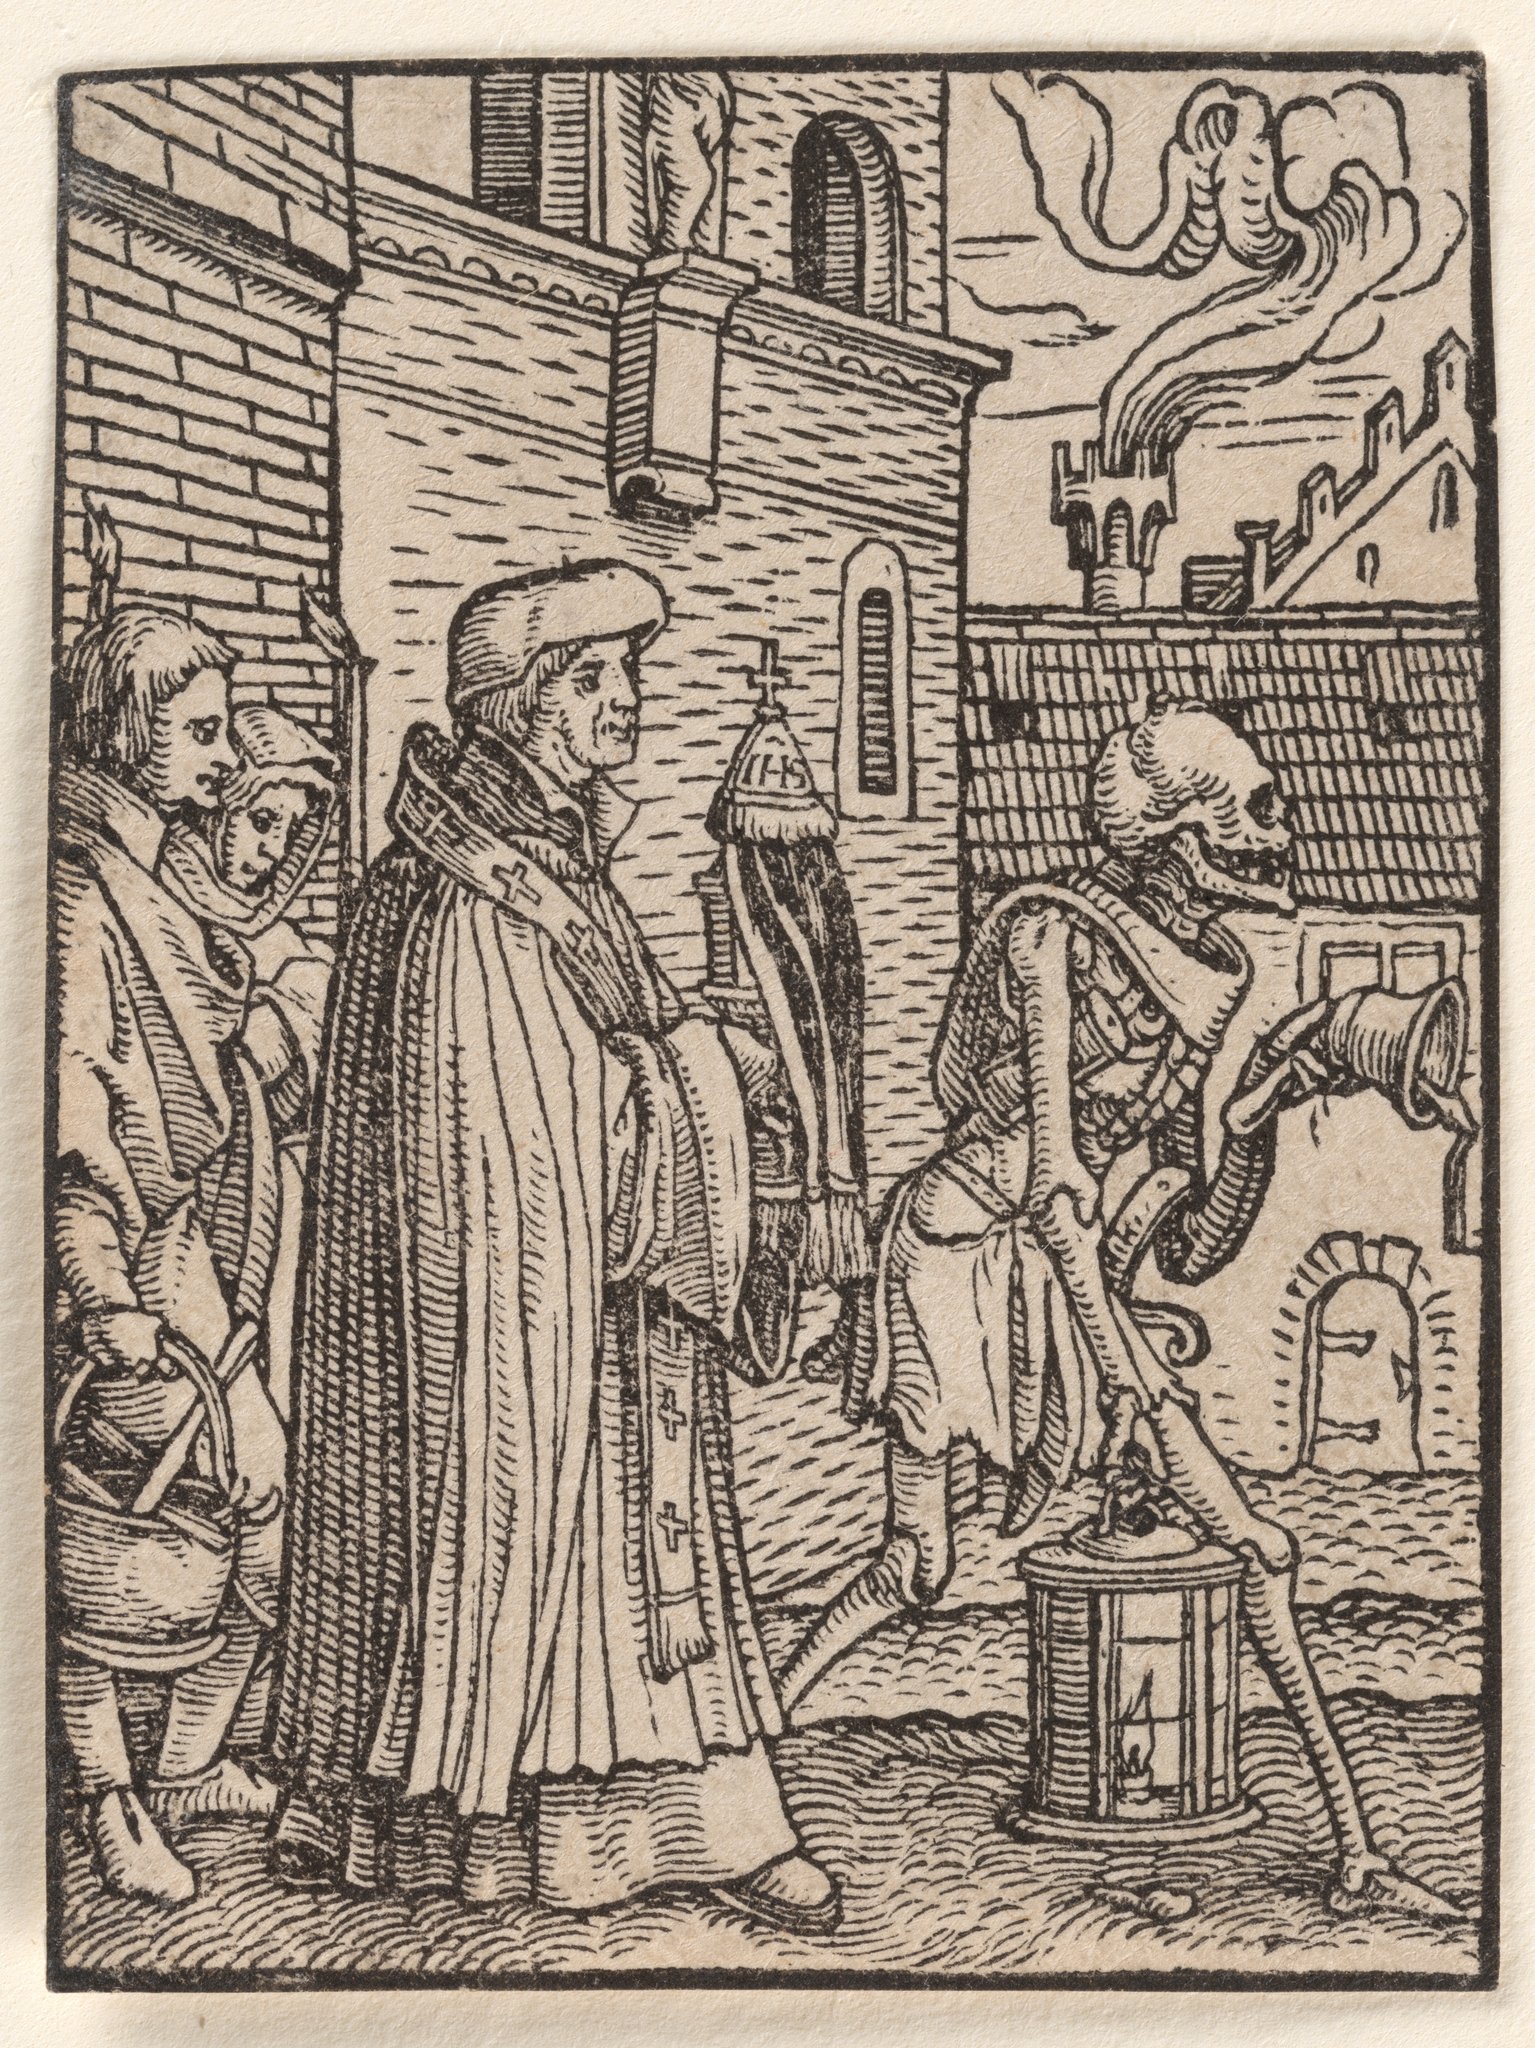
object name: print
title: The Priest, from "The Dance of Death"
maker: hans holbein the younger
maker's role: artist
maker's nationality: german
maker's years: 1497-1543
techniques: woodcut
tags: skeletons,men,lamps,priests